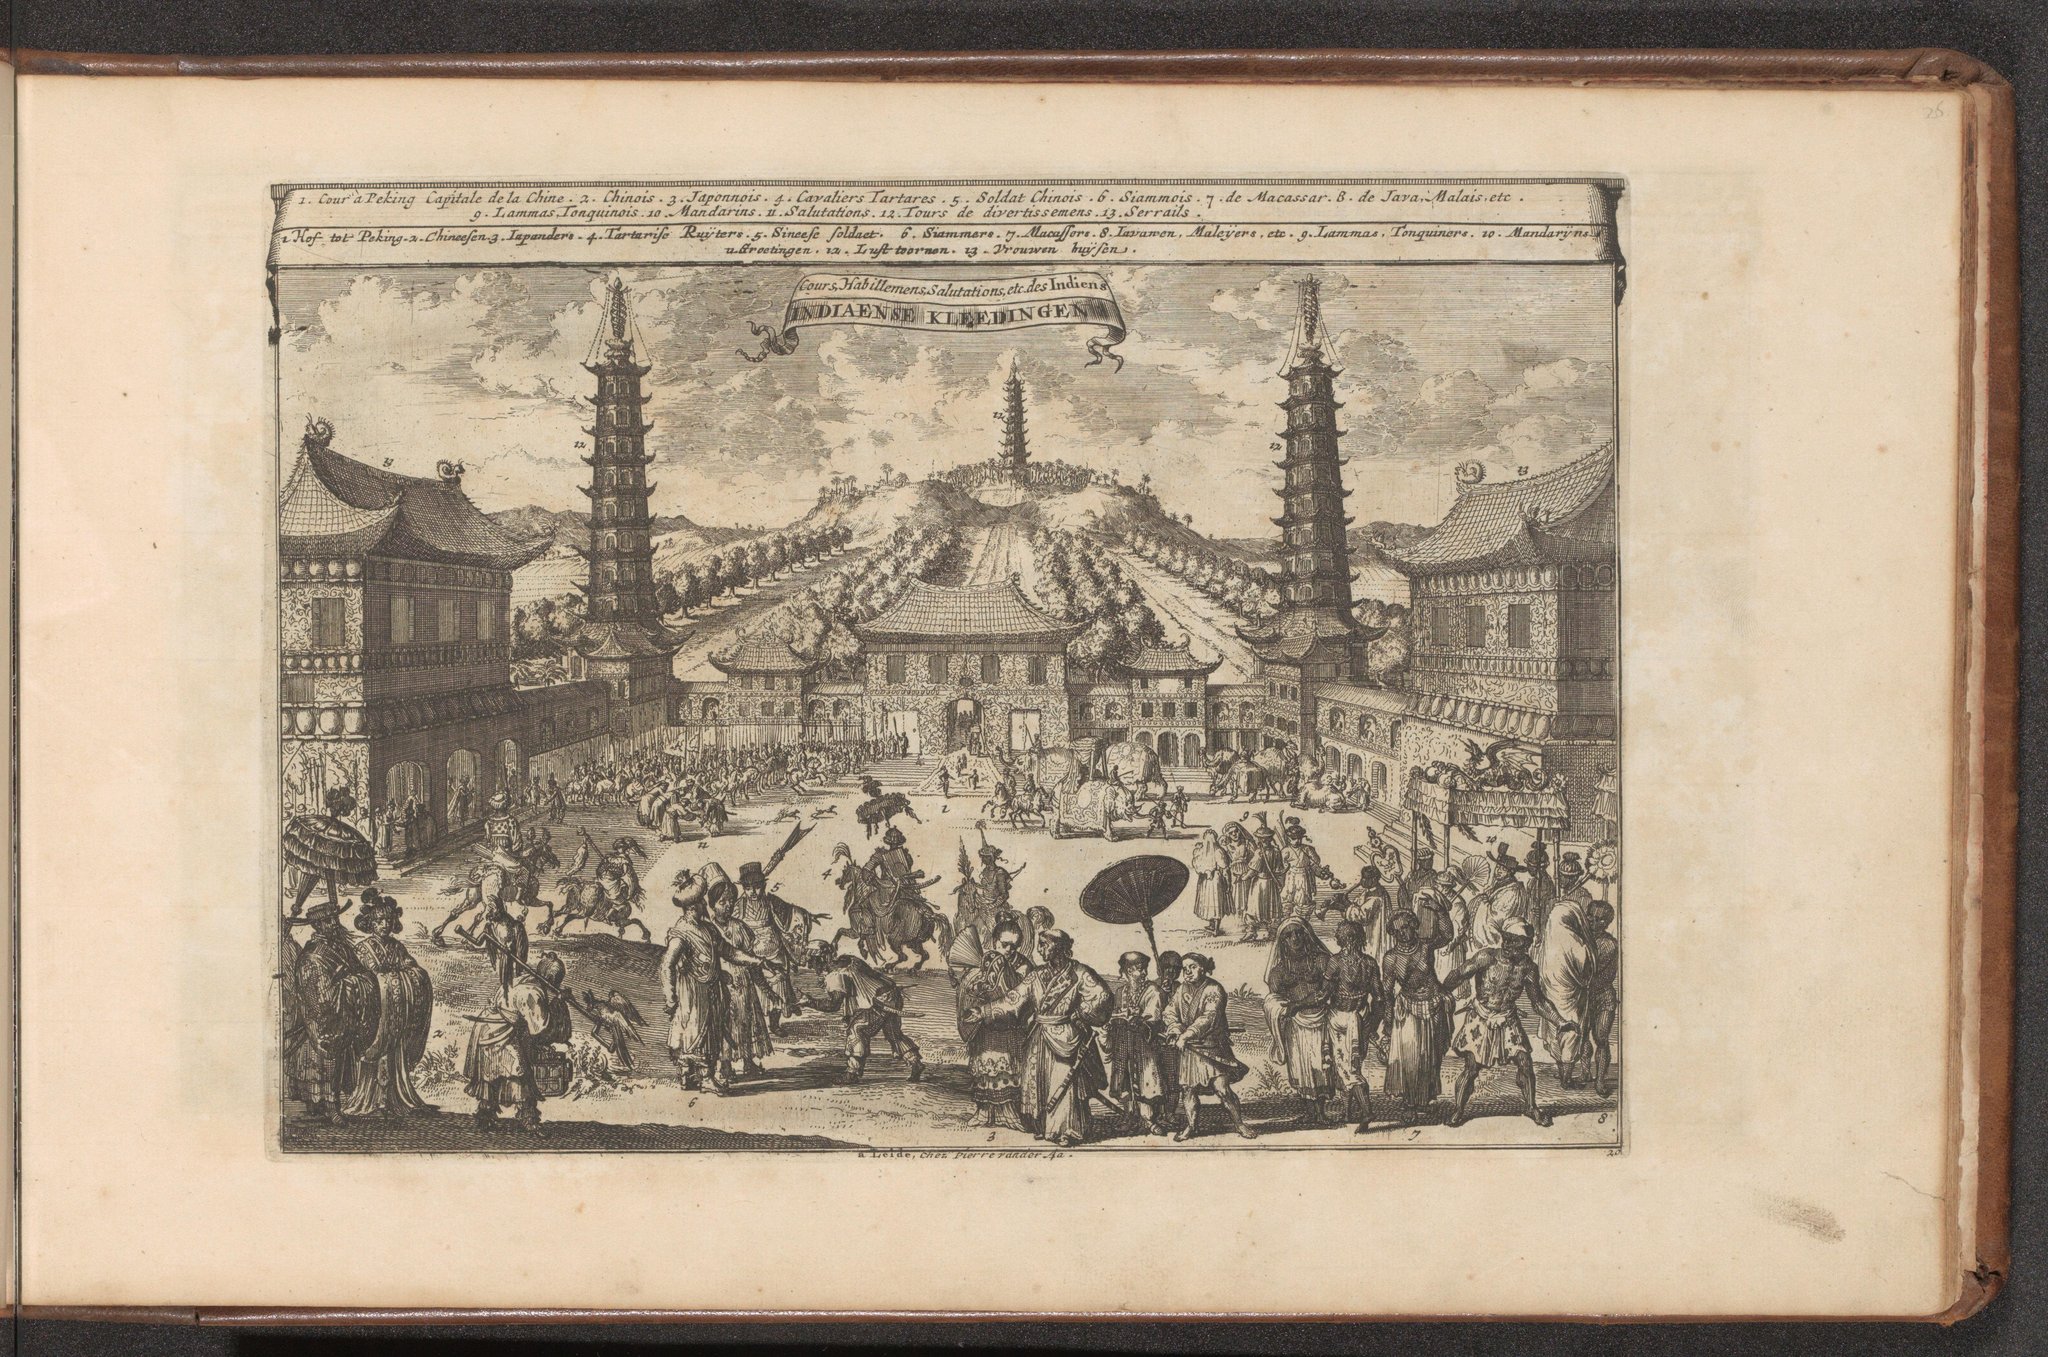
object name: print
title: Hof in Peking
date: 1682-1733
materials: paper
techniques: etching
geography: leiden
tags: fashion, clothing, asiatic races and peoples, china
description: Het hof in Peking met drie pagodes. Op een plein lopen Japanners, Chinezen, Tartaarse ruiters, Siammers (inwoners van Siam, nu Thailand), Makassars, Javanen etc. De voorstelling laat zien hoe de verschillende groepen gekleed gingen. Met een legenda in het Nederlands en het Frans. De prent maakt deel uit van een album.